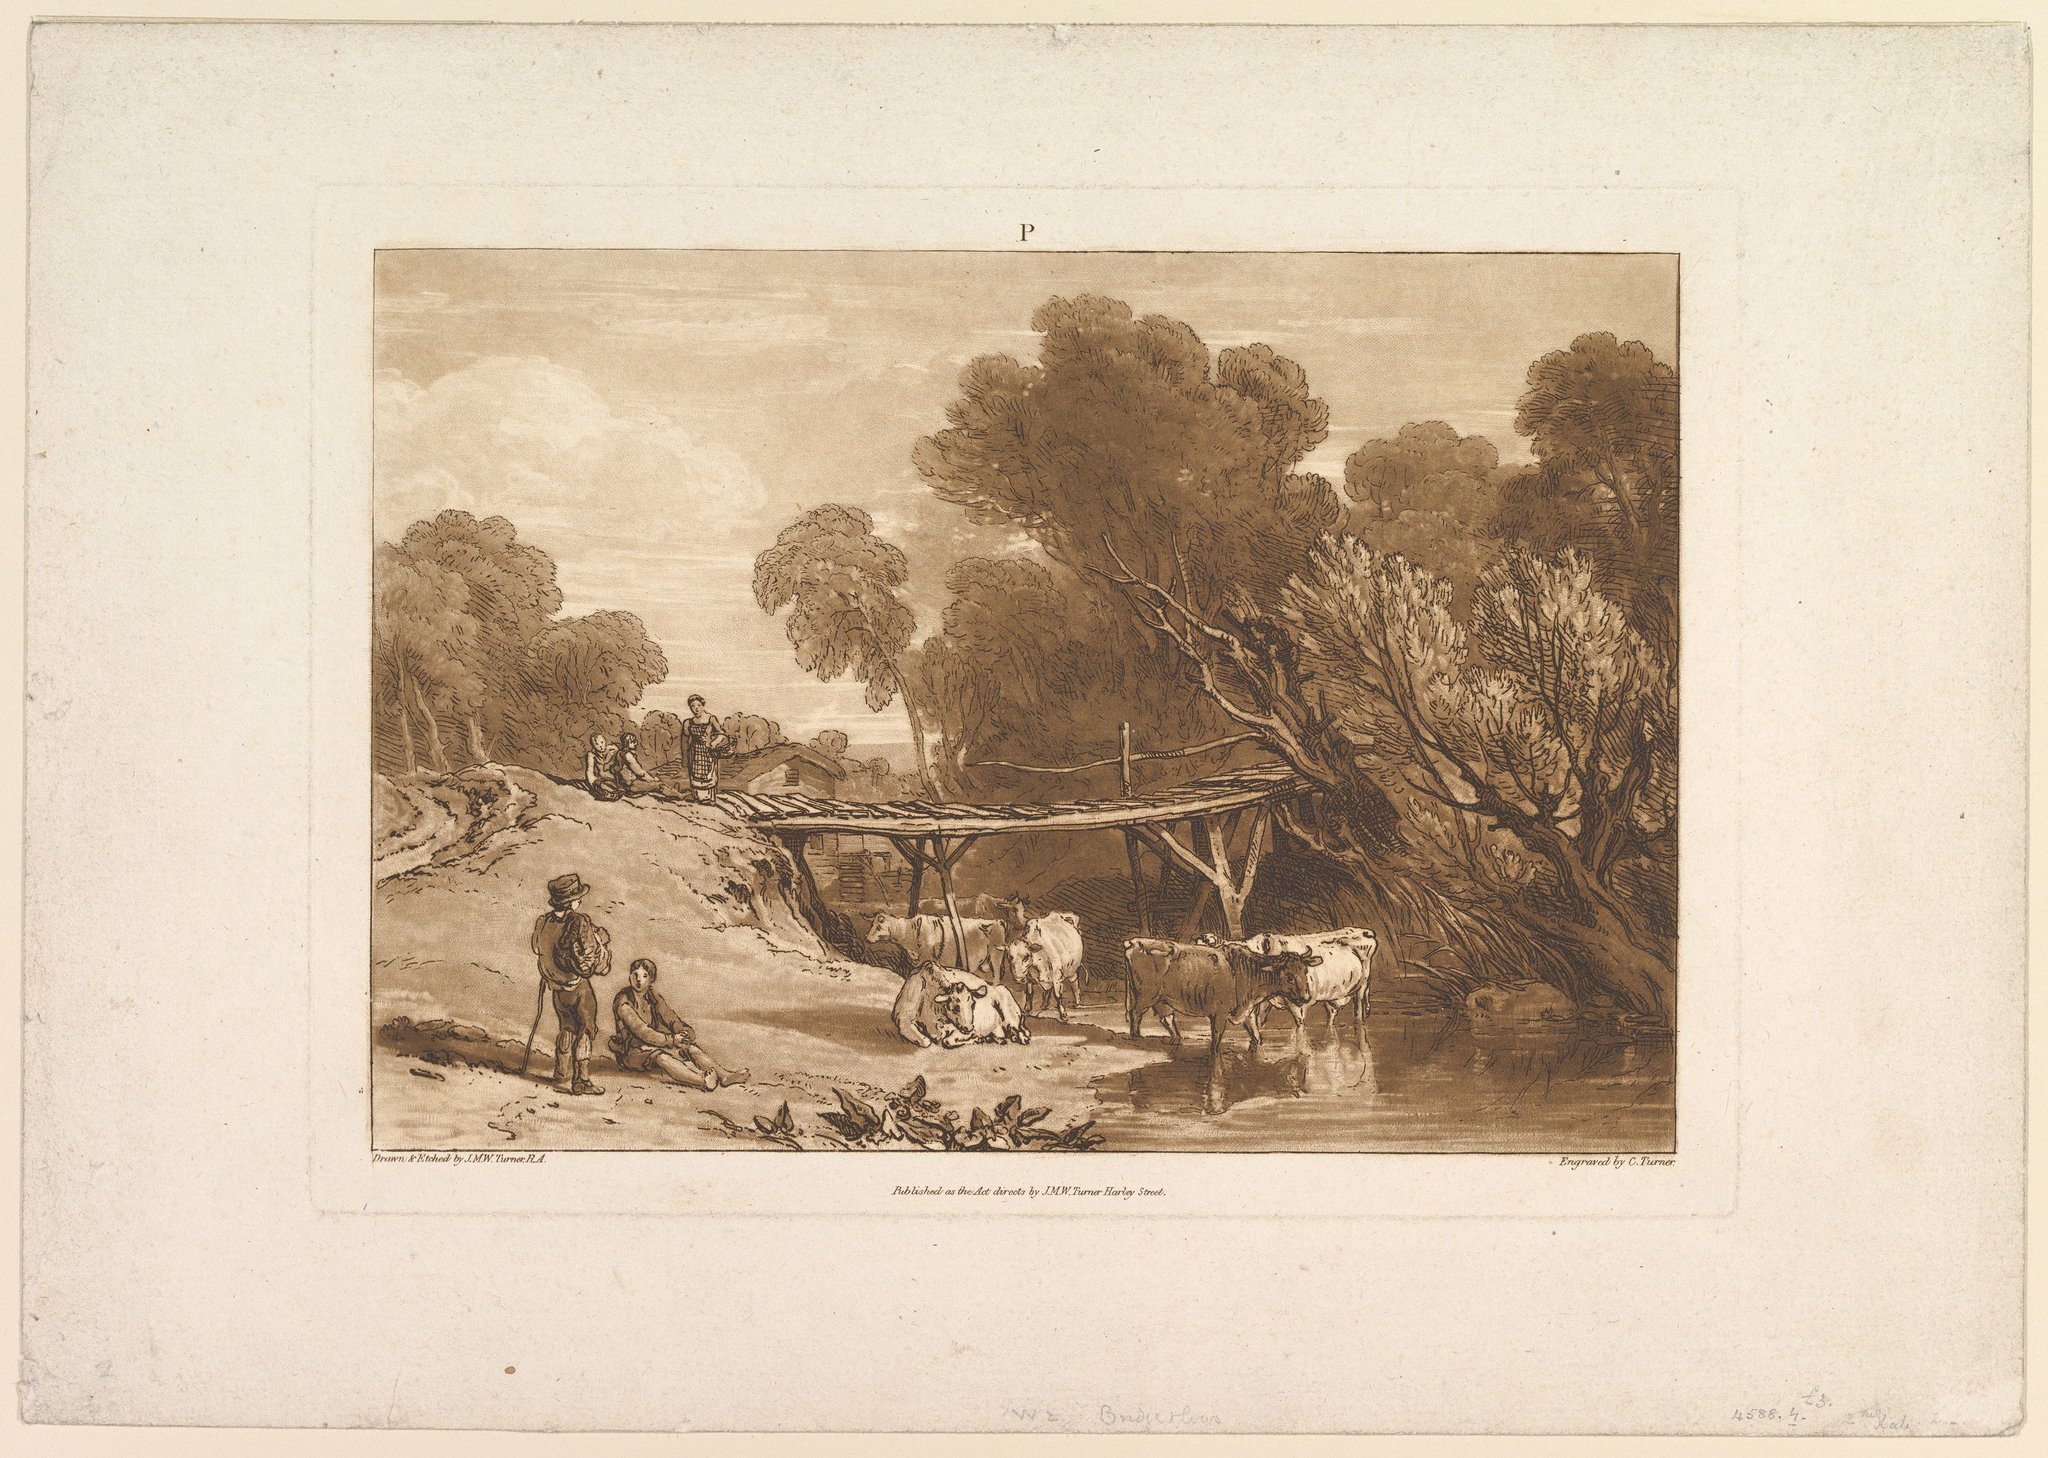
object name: print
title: Bridge and Cows, part I, plate 2 from "Liber Studiorum"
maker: joseph mallord william turner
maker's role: artist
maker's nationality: british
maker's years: 1775-1851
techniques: etching, mezzotint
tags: bridges,cows,landscapes